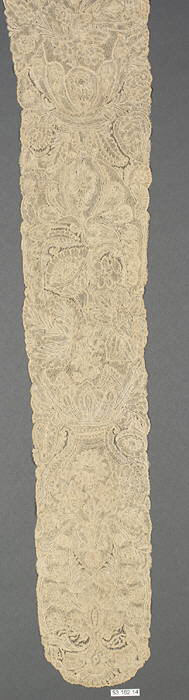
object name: lappet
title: Pair of lappets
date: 1701-1733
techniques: lace